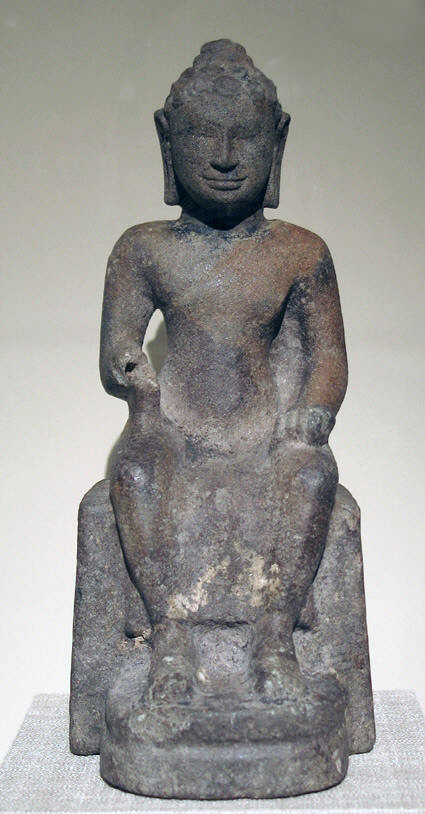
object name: figure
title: Seated Buddha with Legs Pendant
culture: vietnamese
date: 601-700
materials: stone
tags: buddhism,buddha